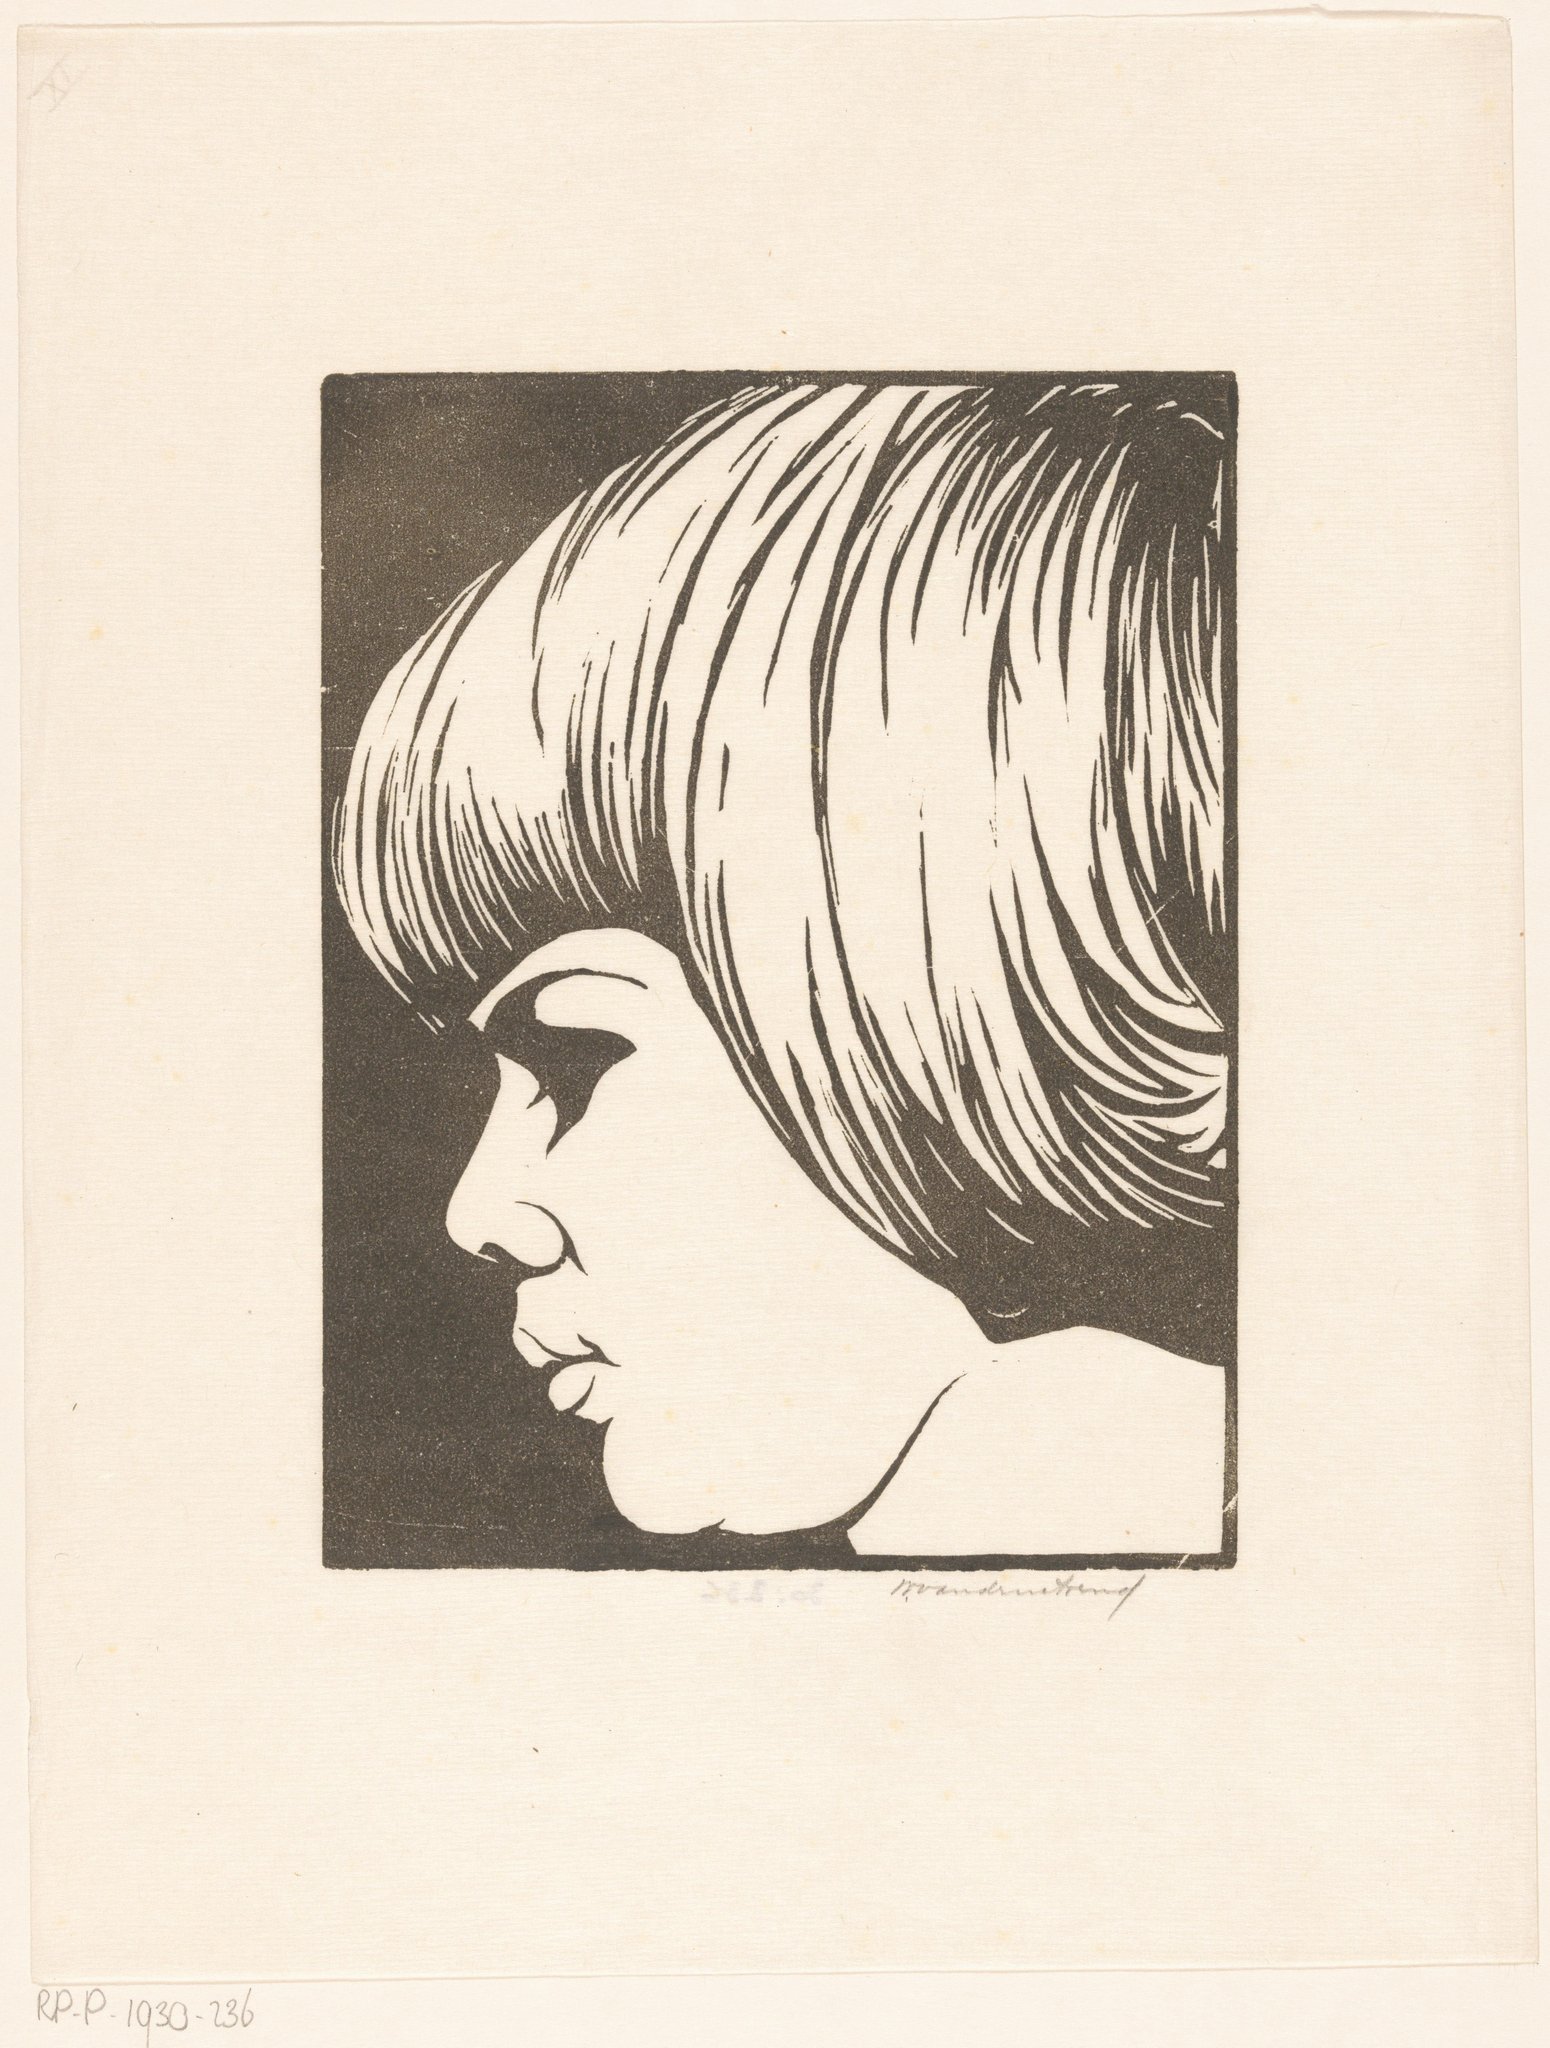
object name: print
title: Kinderkop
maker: willem van den arend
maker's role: painter, print maker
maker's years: 1875-1954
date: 1885-1930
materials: paper, ink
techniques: woodcut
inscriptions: signature: ‘W.vandenArend’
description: Gestileerde kop van een meisje, en profil.